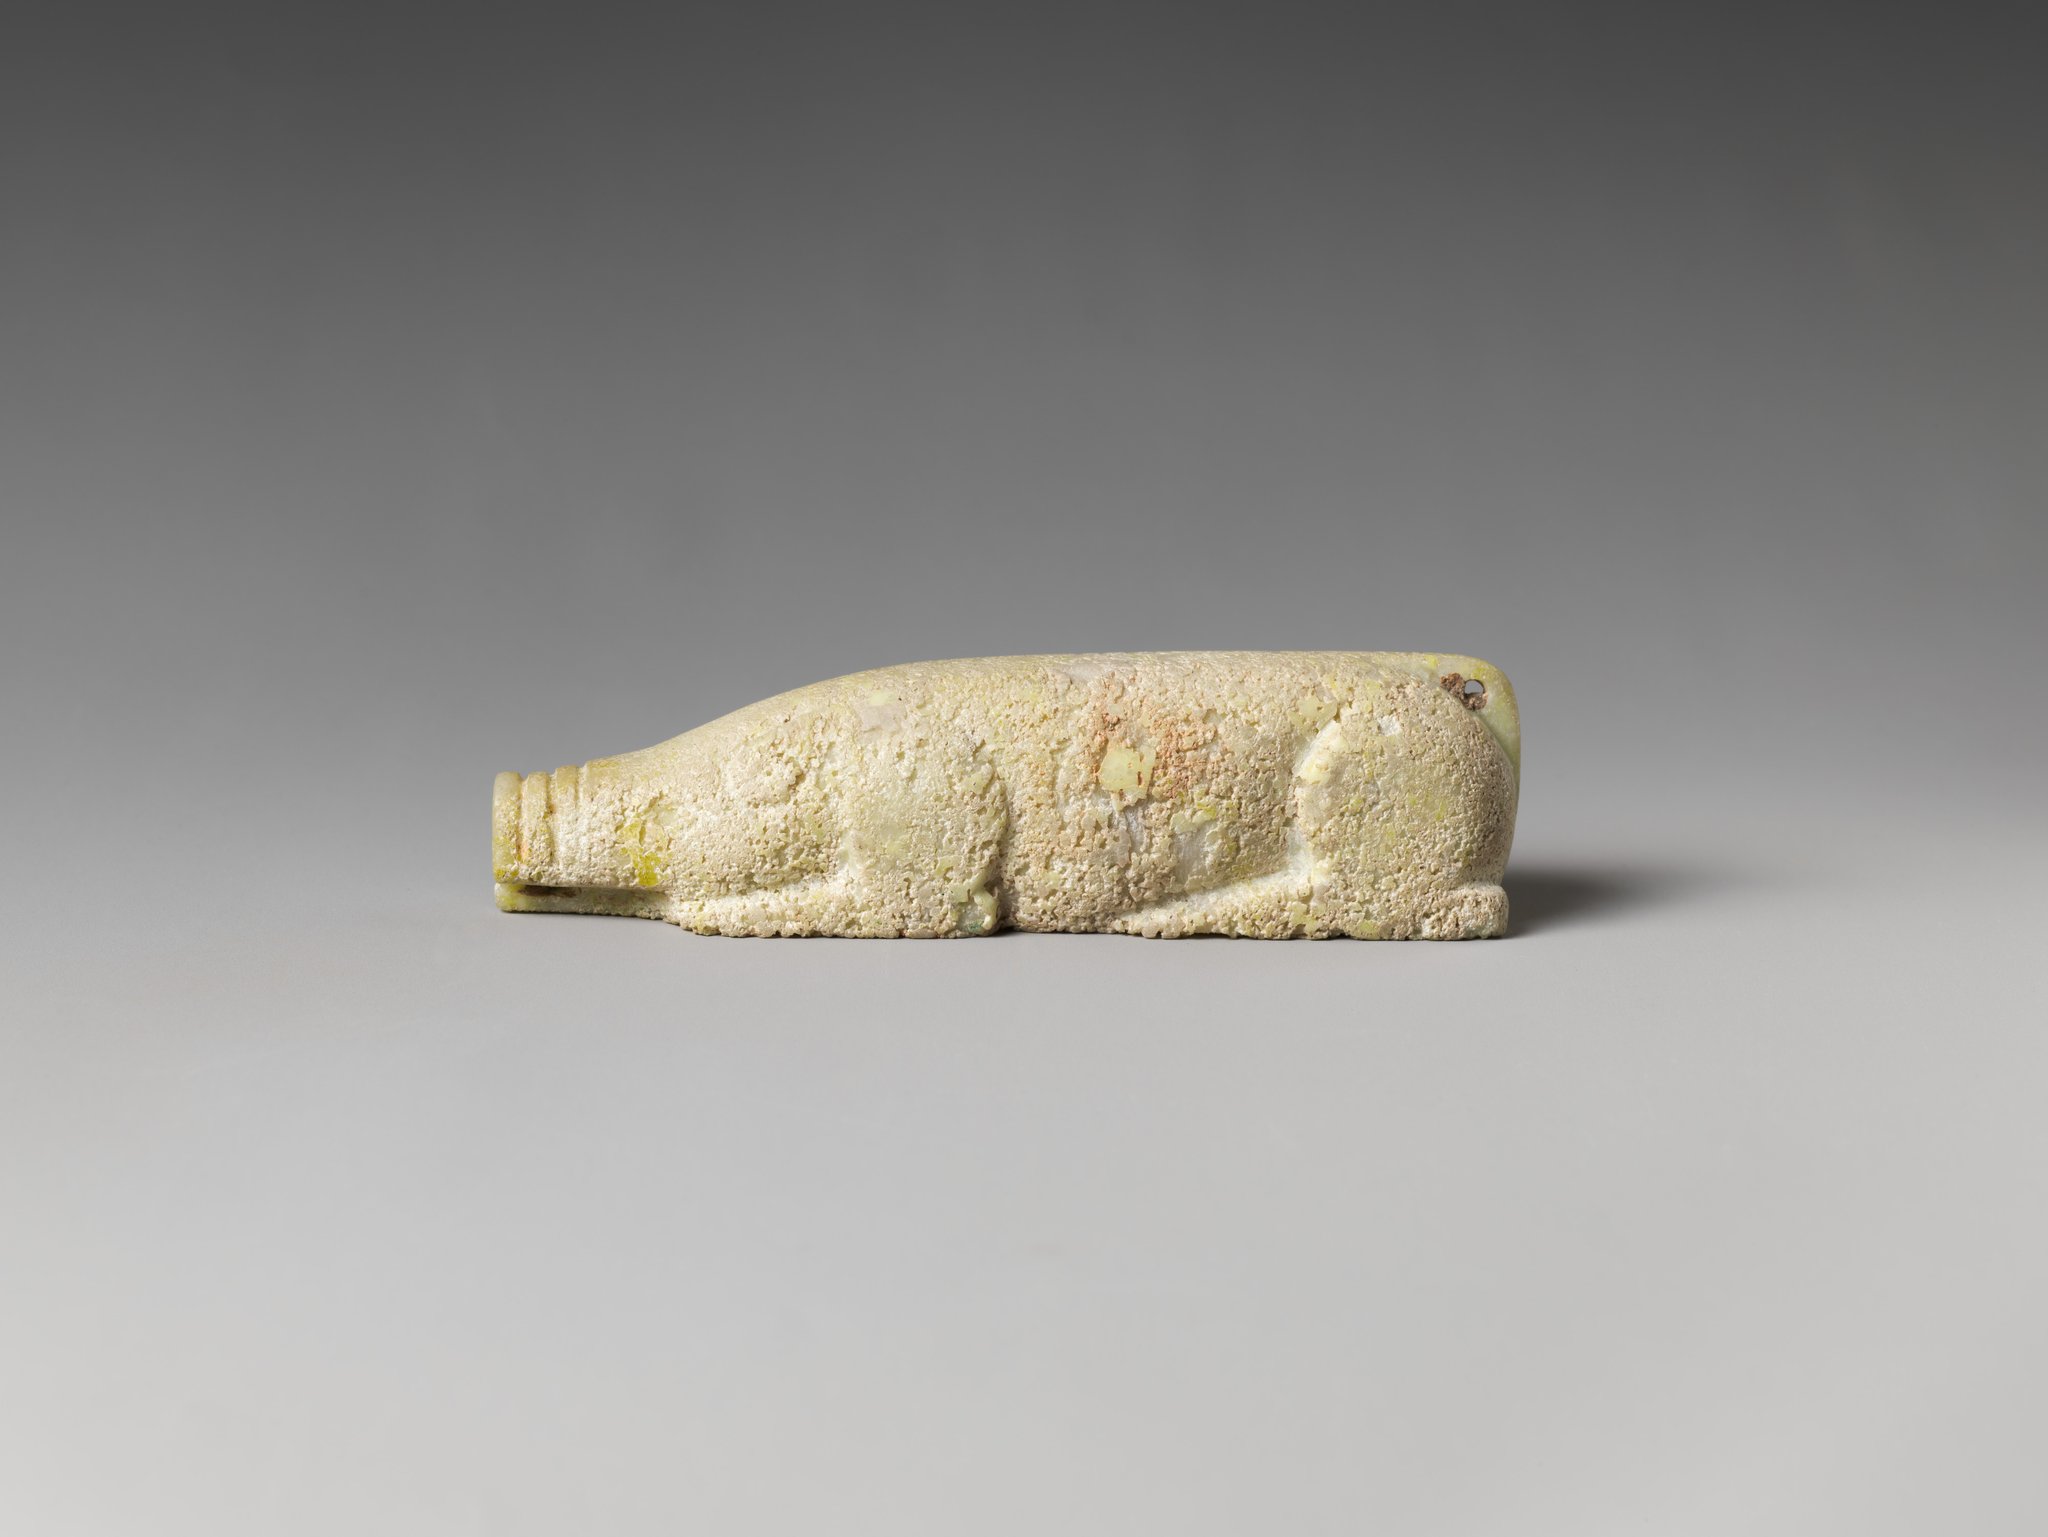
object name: figure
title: Pig in Recumbent Position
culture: chinese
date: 1-200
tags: pigs